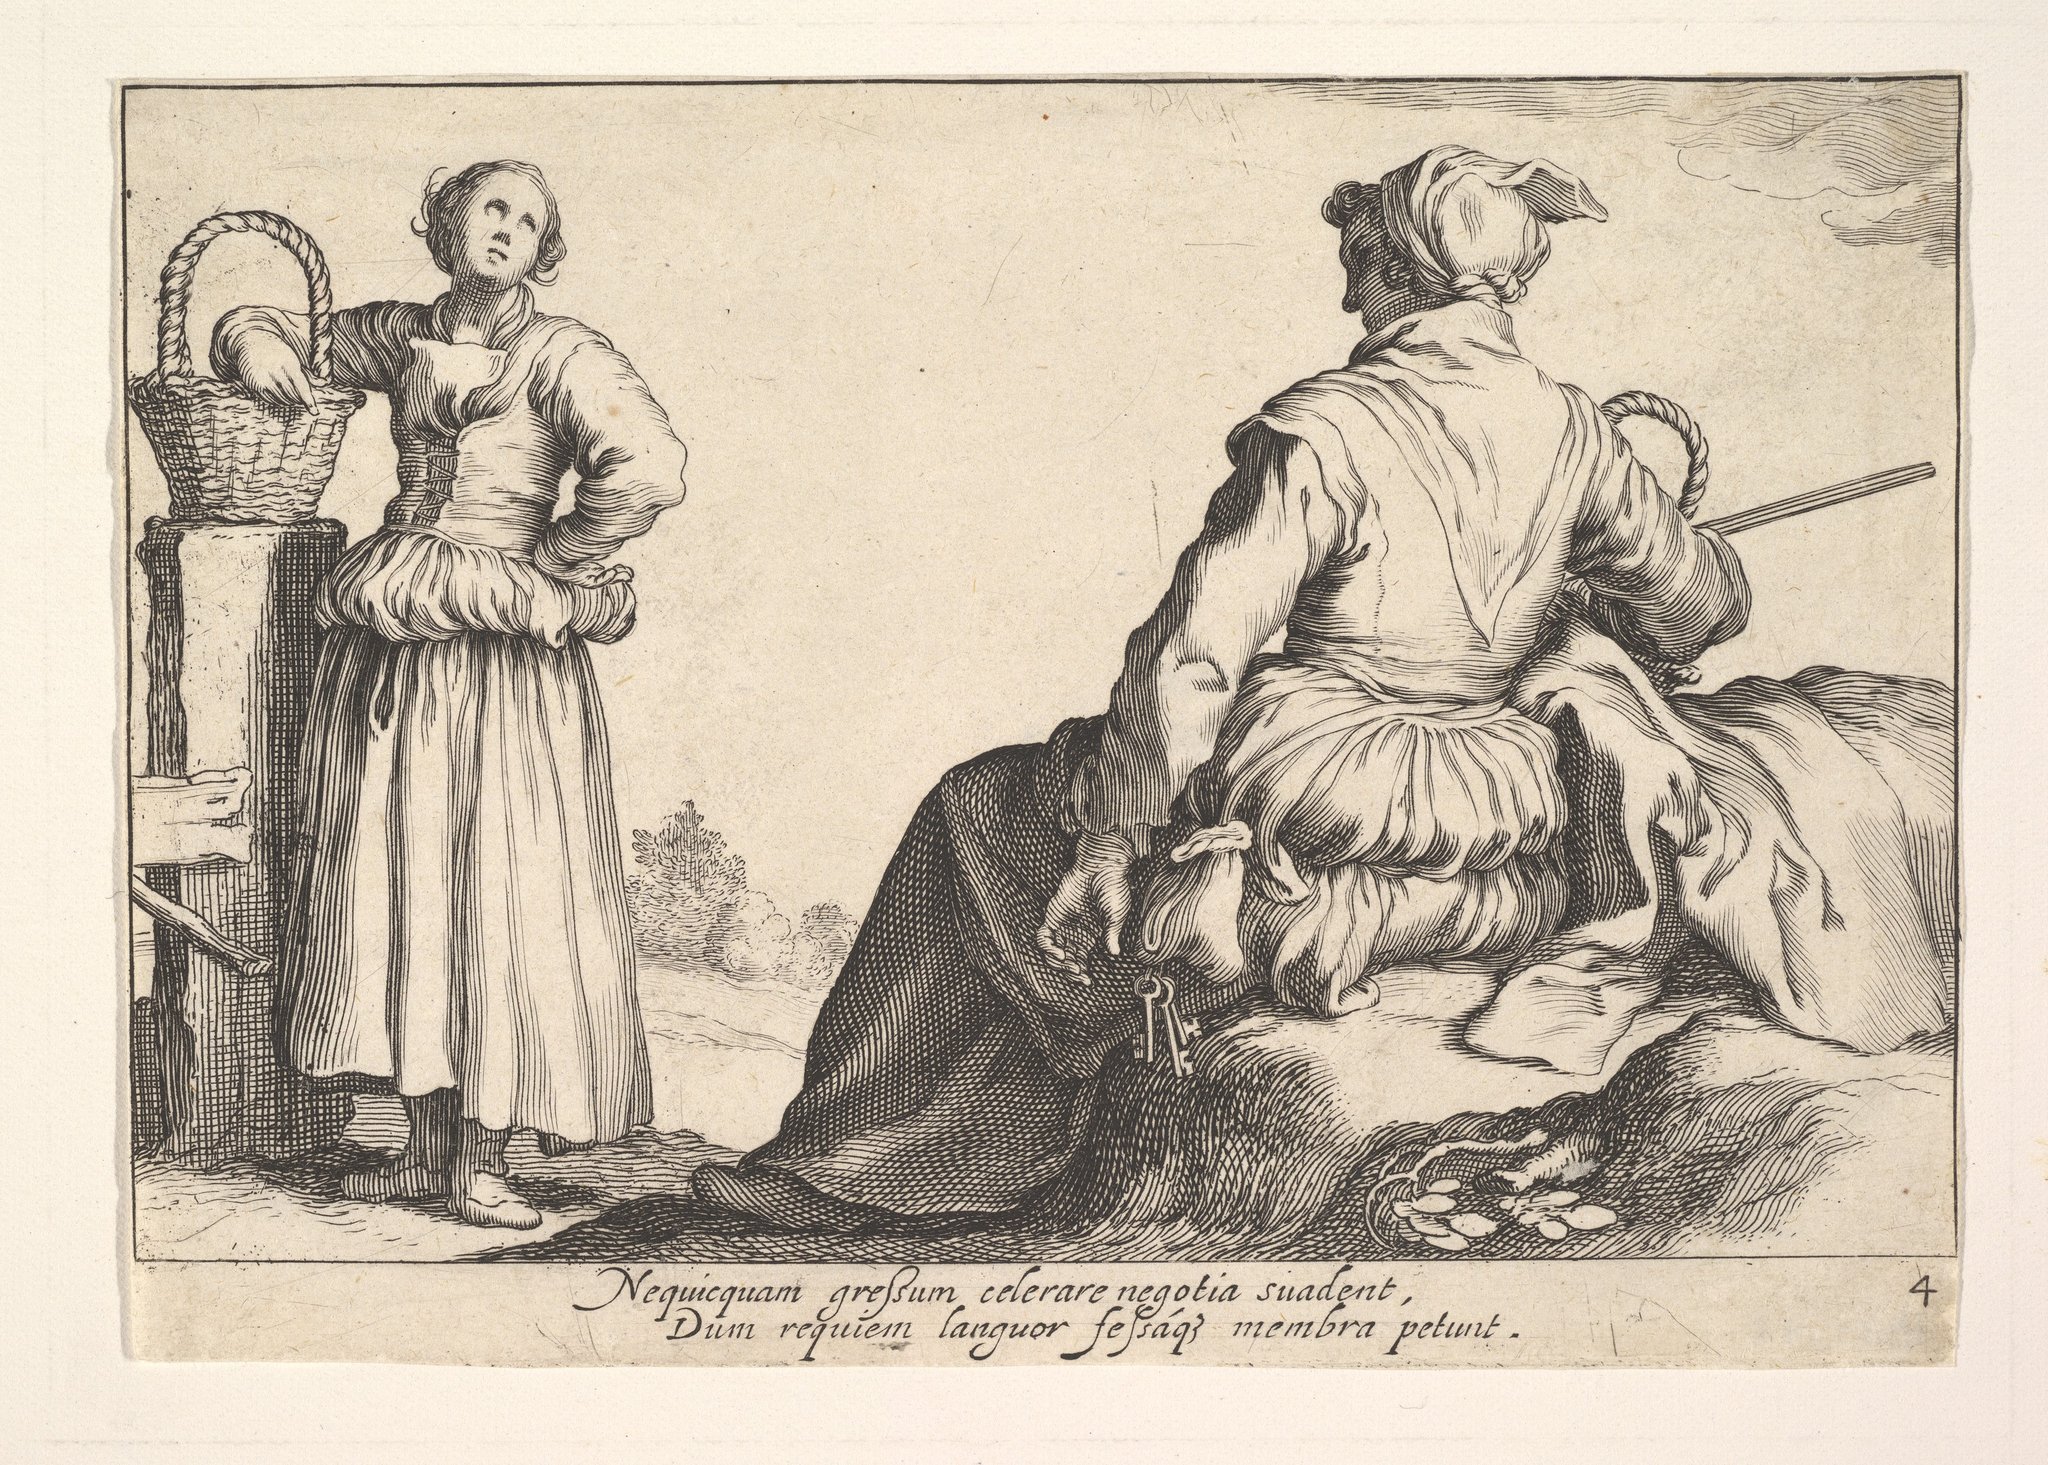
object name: print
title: Pleasures of Occupation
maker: cornelis bloemaert (ii)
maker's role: artist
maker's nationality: dutch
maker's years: 1603-1684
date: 1620-1684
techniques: engraving, etching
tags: women